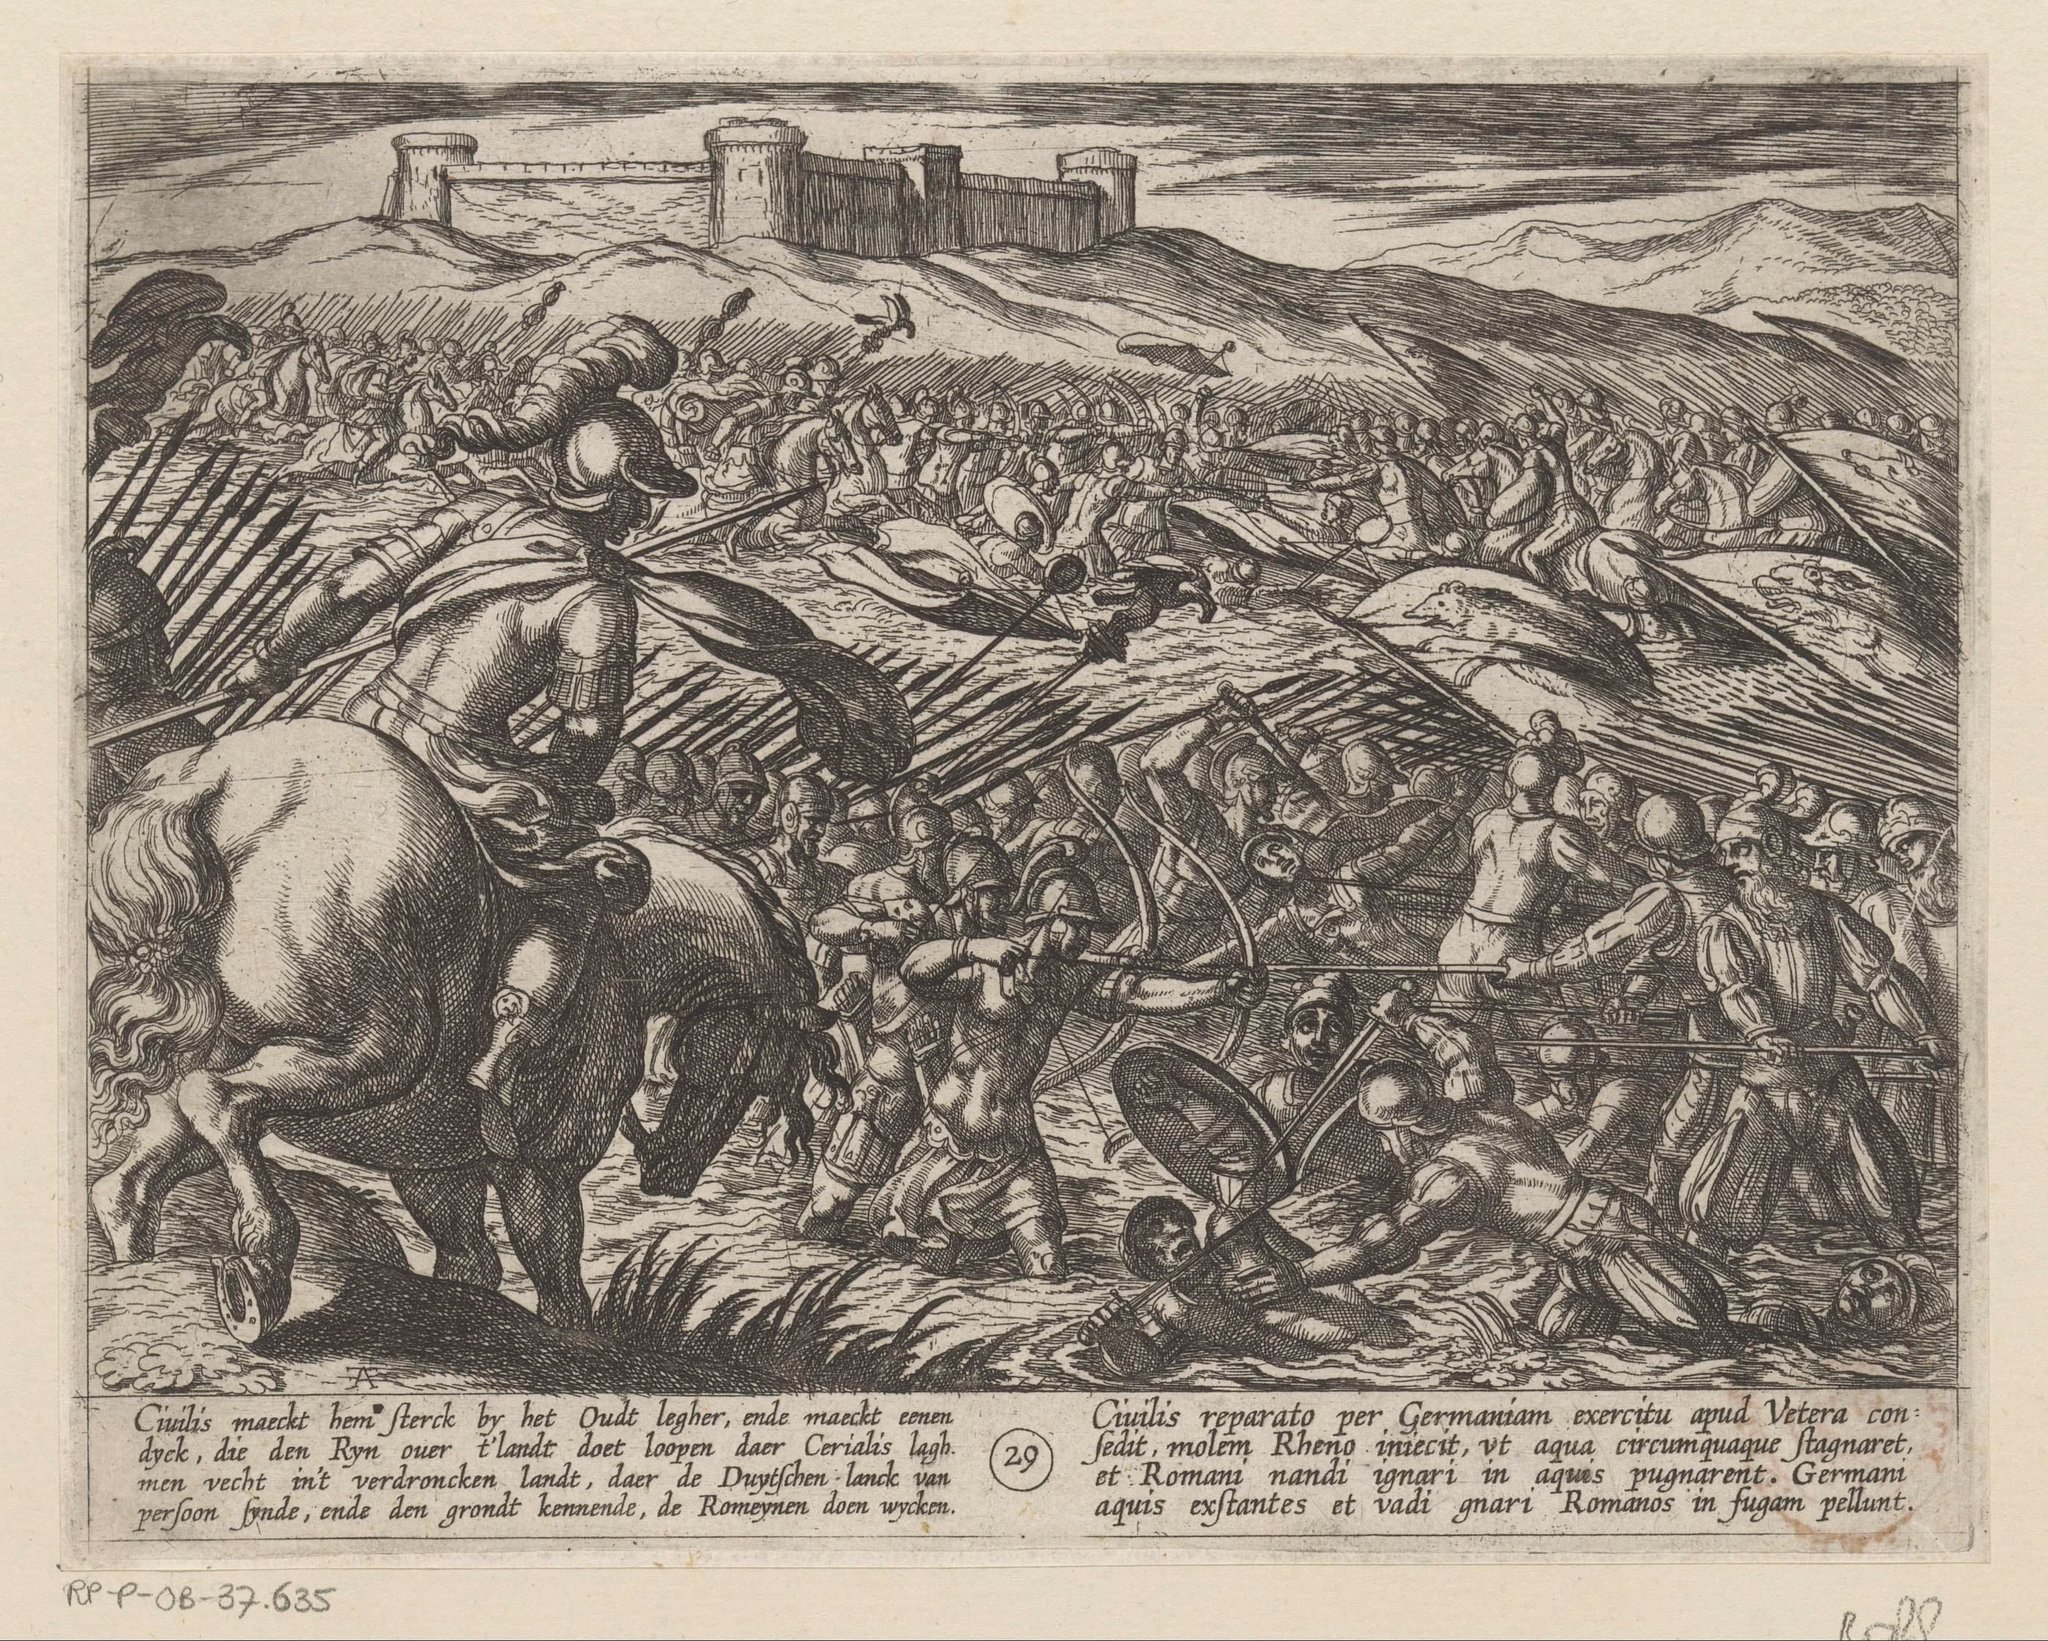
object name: print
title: Julius Civilis zet het land onder water met behulp van dijken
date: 1611-1612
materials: paper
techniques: etching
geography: southern netherlands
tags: flood, high tide, battle, the soldier; the soldier's life, (story of) julius claudius civilis, extinct, 'historical' peoples (with name)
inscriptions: collector's mark: Lugt 240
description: Julius Civilis zet het land tijdens een strijd tegen de Romeinen onder water met behulp van dijken. Op de achtergrond een fort. Onderschrift in het Nederlands en in het Latijn.